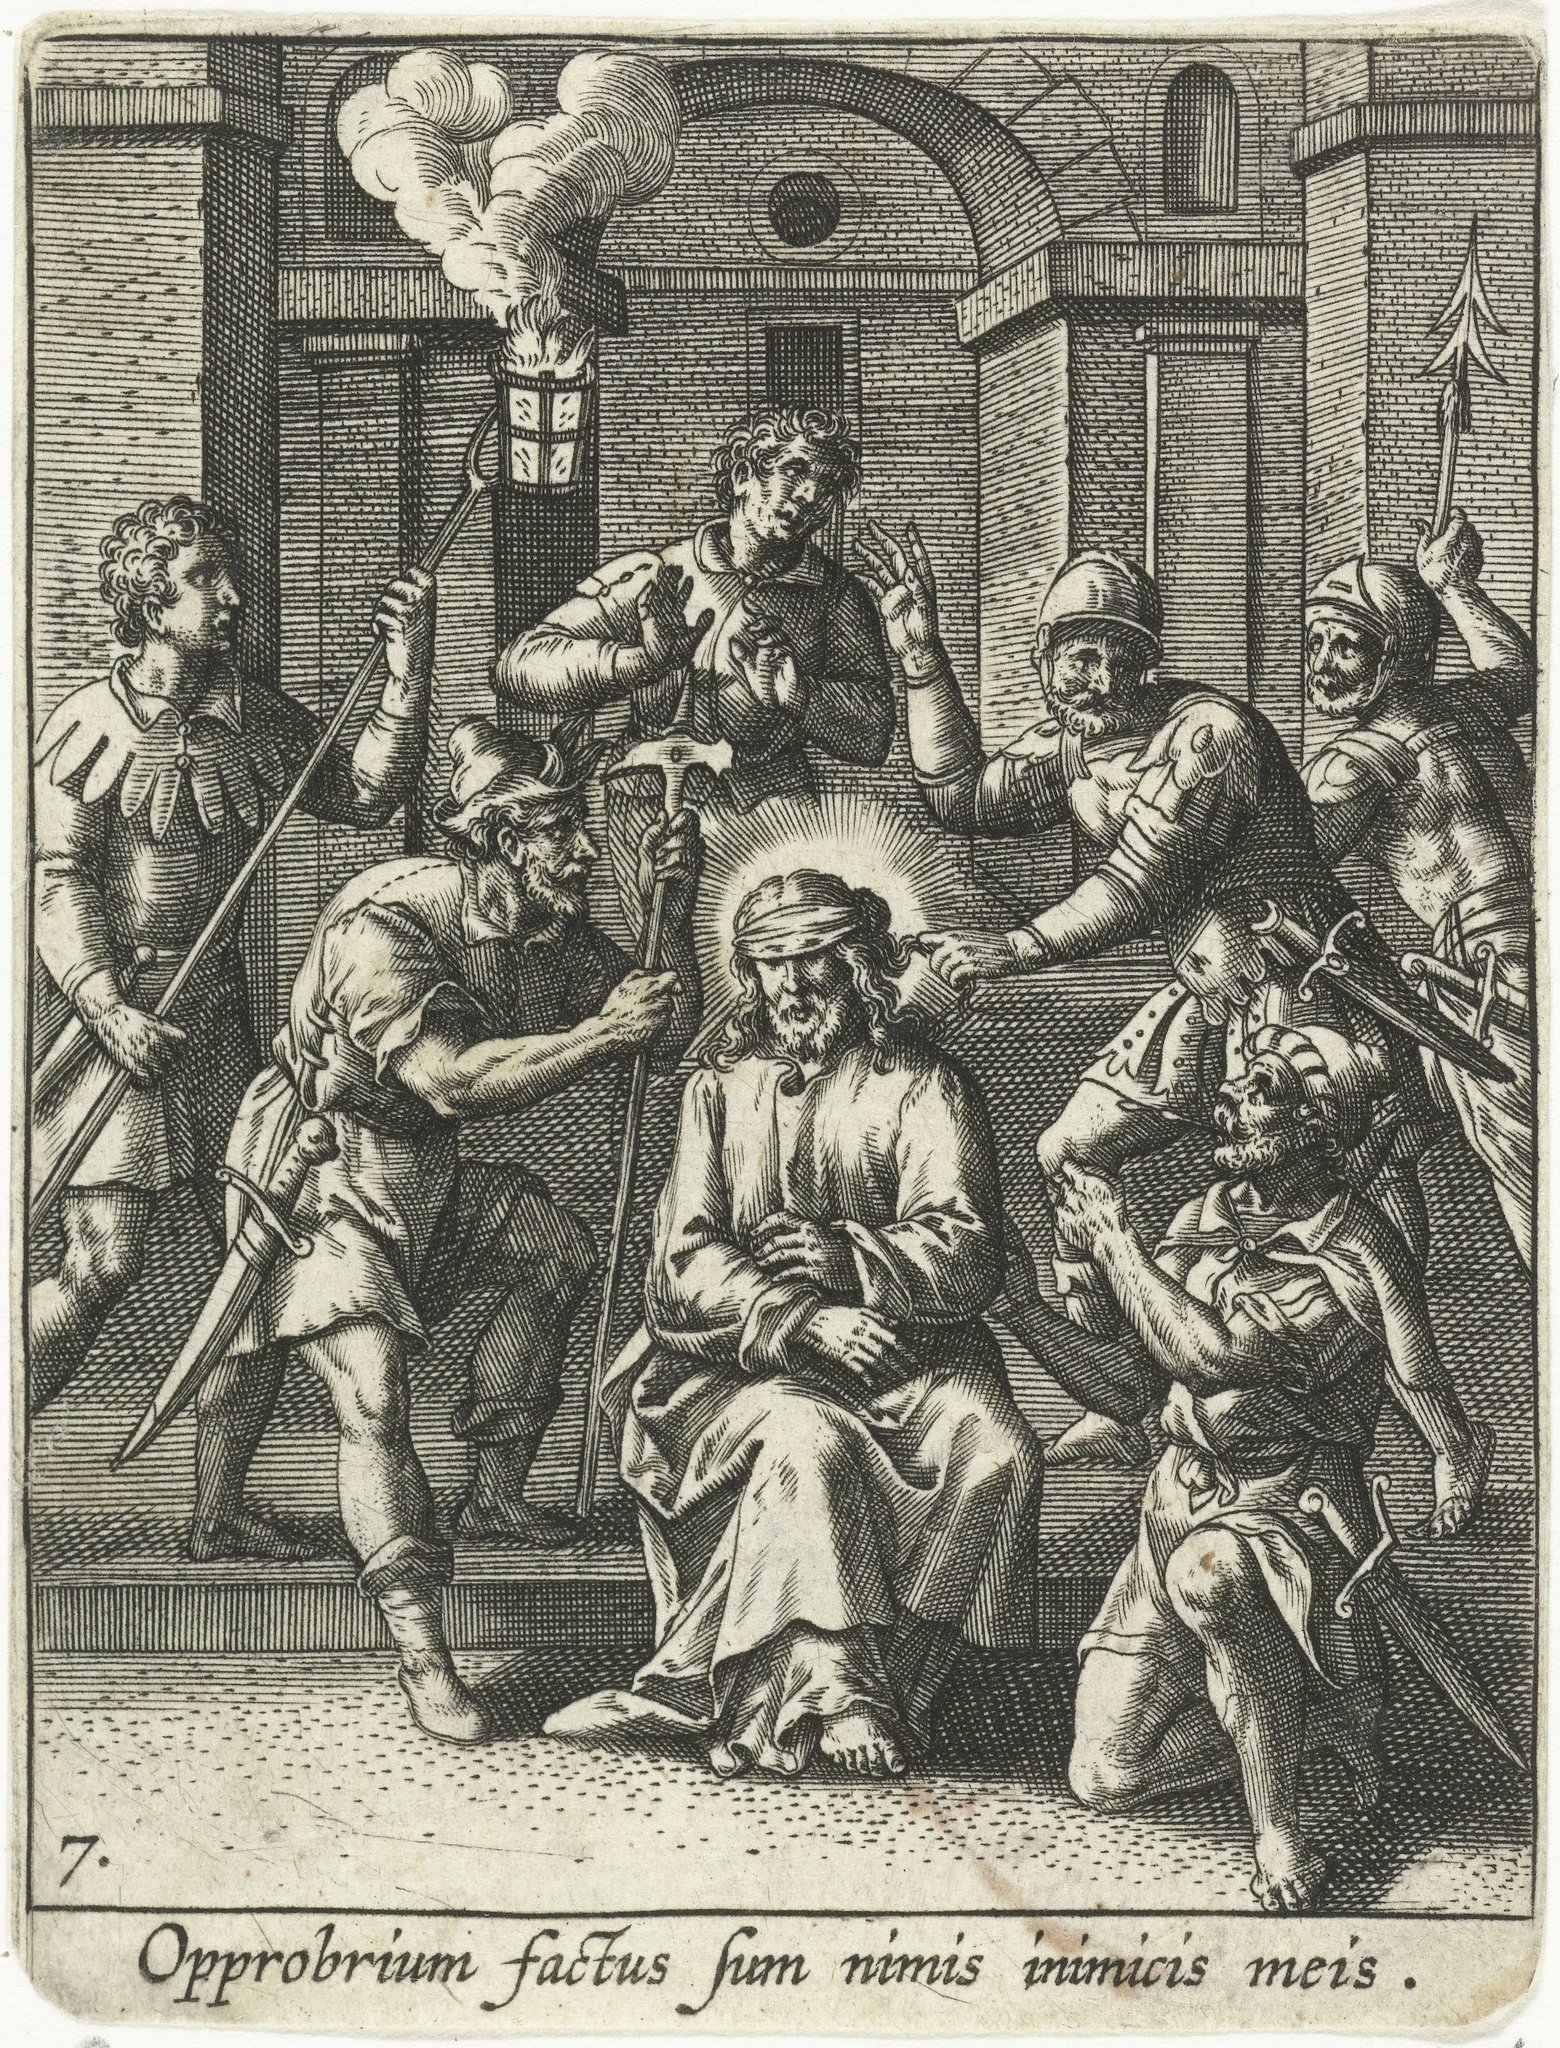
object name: print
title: Passio et Resvrrectio D.N. Iesv Christi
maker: adriaen collaert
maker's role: draughtsman, print maker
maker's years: 1560-1618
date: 1570-1618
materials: paper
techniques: engraving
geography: antwerp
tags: mockings of christ, who may be blindfolded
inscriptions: collector's mark: Lugt 2228, collector's mark: Lugt 240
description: Christus wordt bespot door de soldaten. Hij wordt geblinddoekt en gebonden, geslagen en aan zijn haar getrokken. De prent heeft een Latijns onderschrift